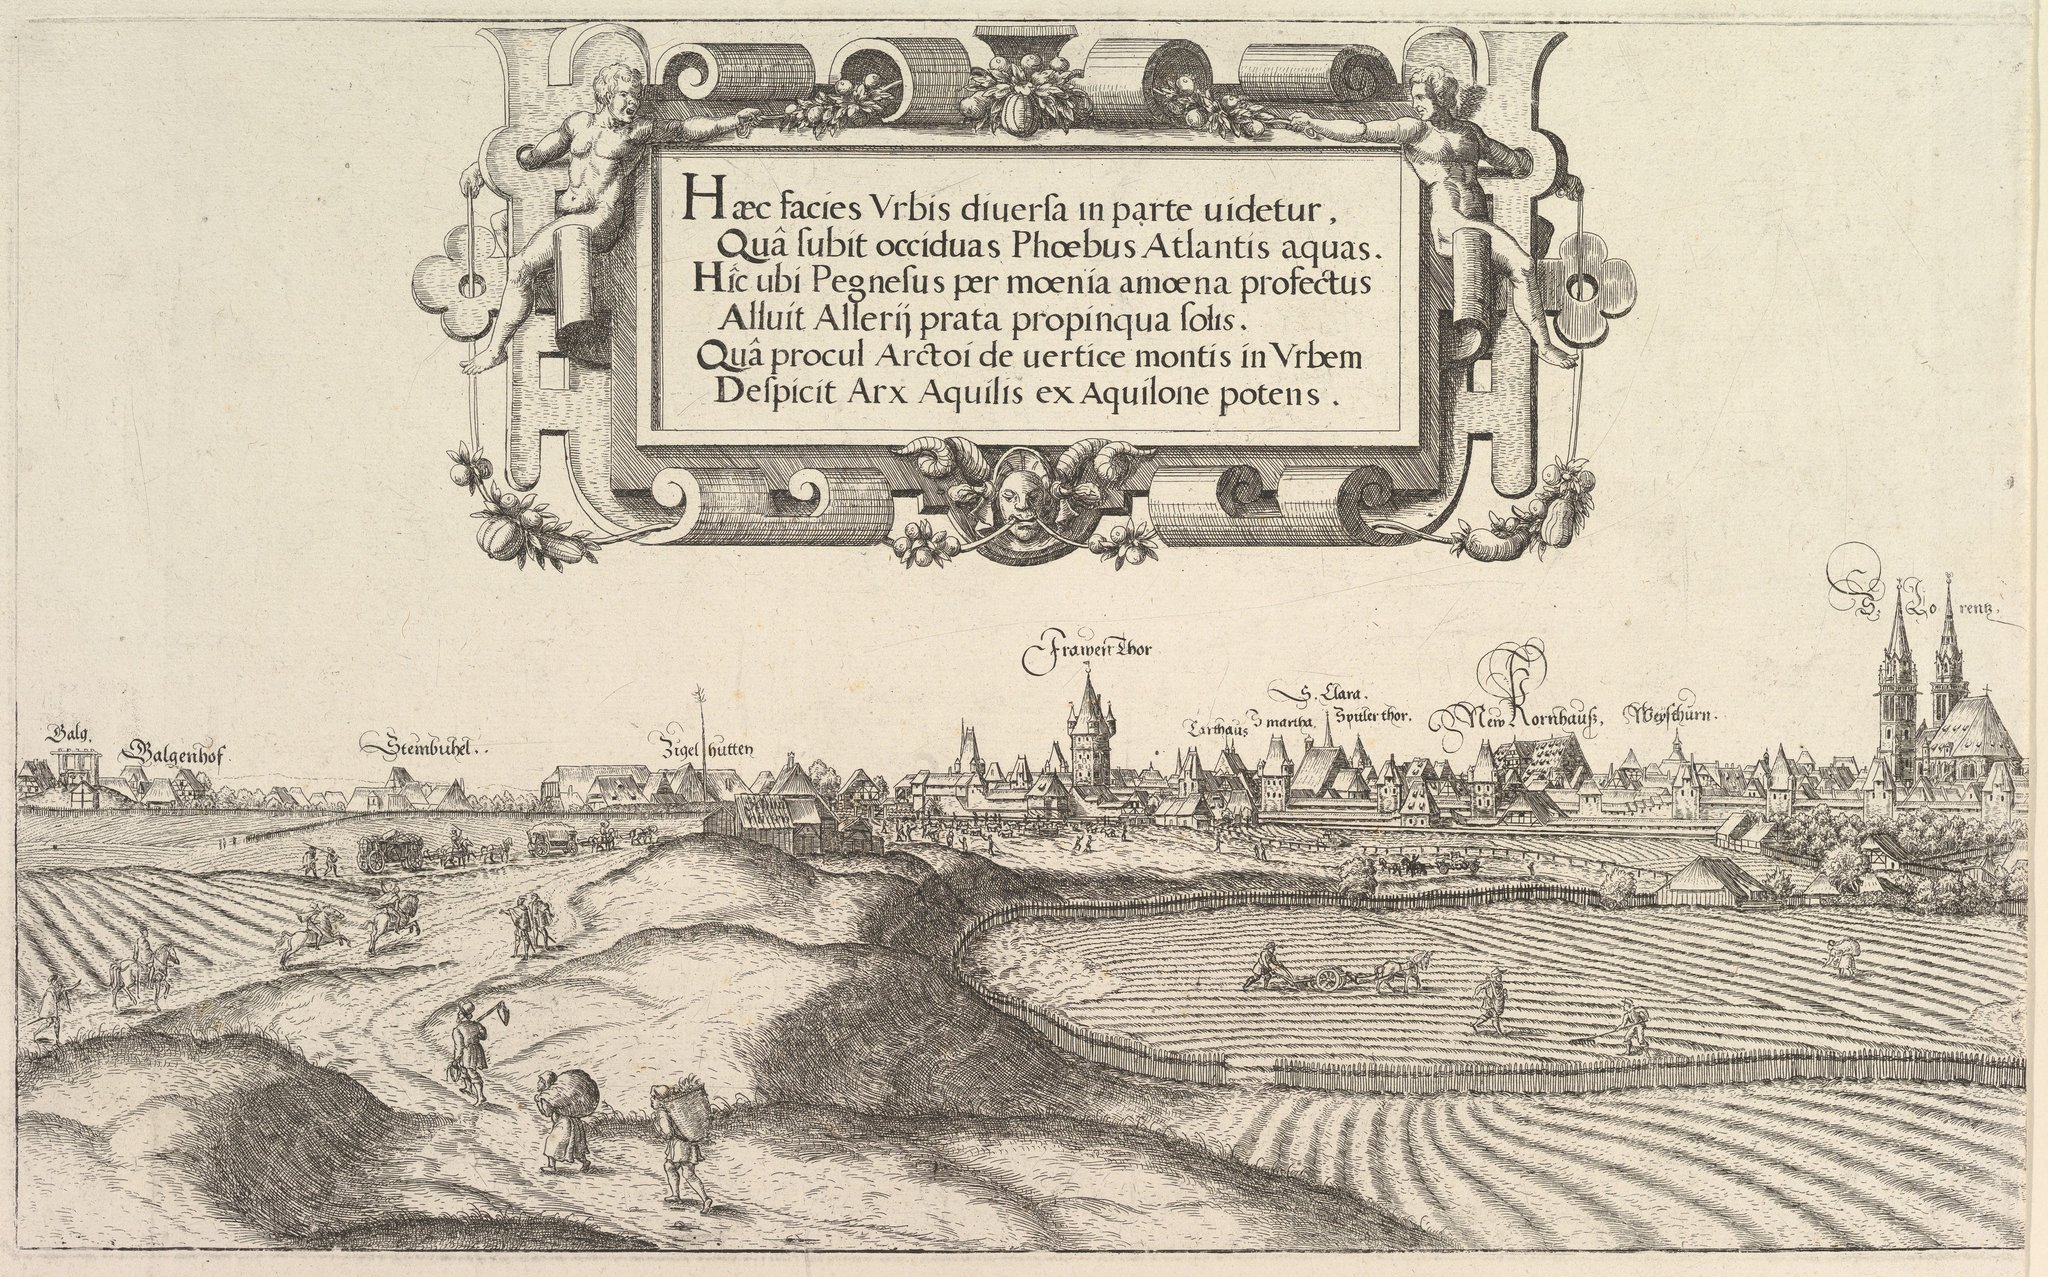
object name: print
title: View of Nuremberg, to the east, left plate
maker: hanns lautensack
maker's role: artist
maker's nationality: german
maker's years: 1515-1566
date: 1552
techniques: etching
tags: human figures,buildings,cities